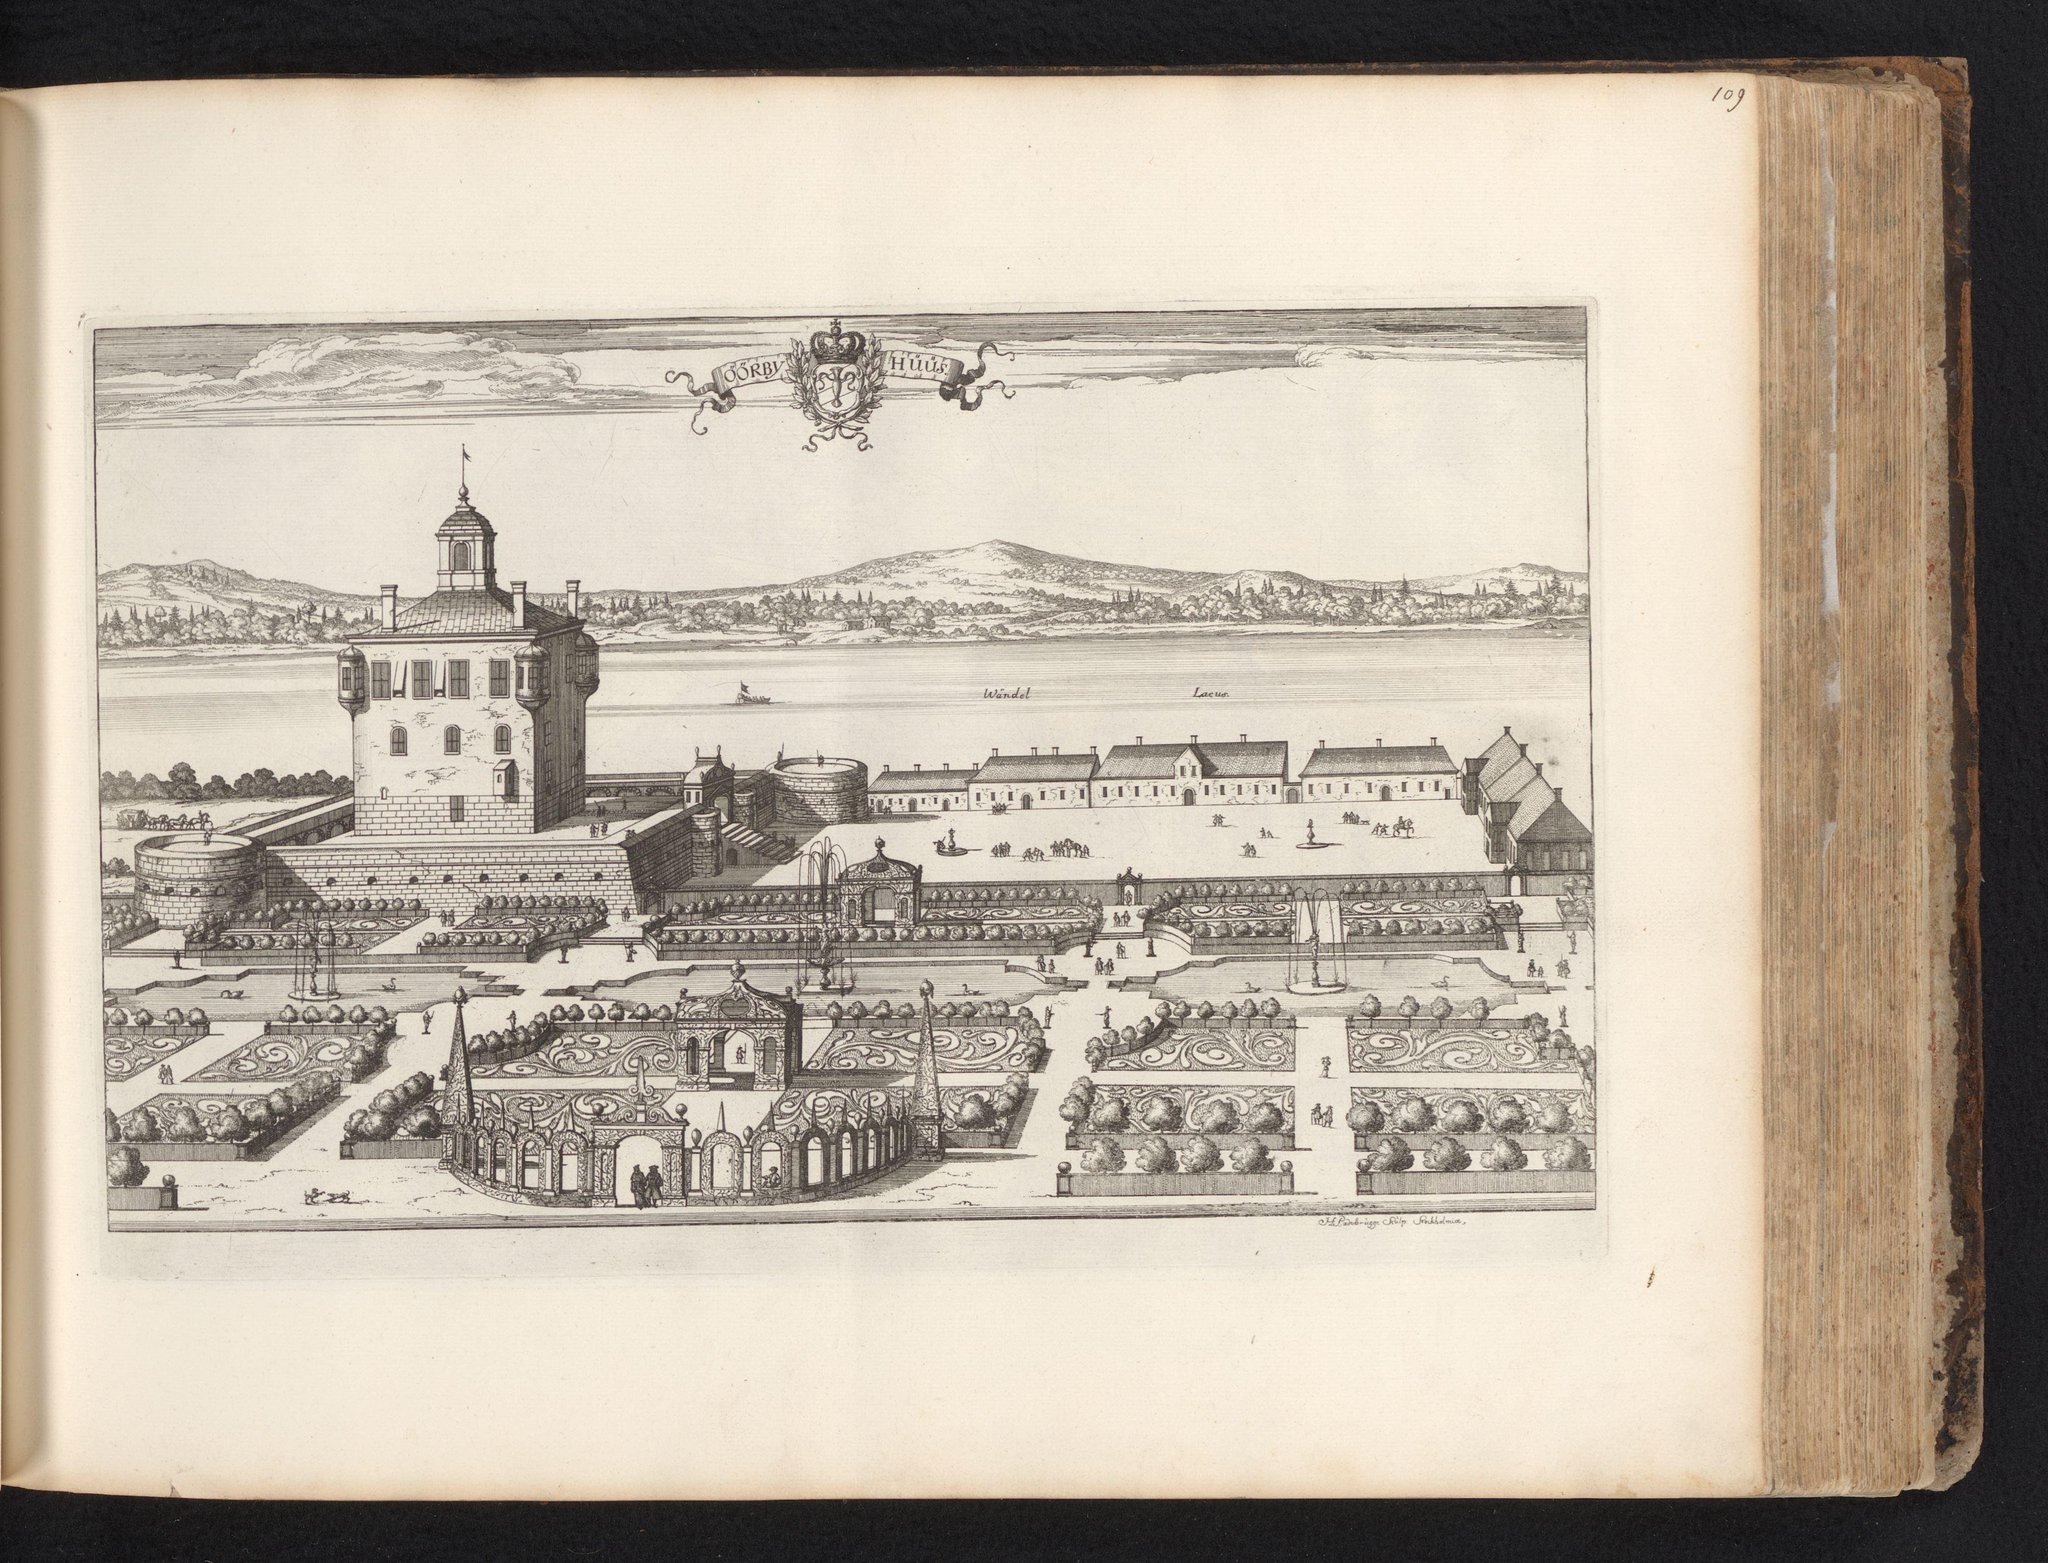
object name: album leaf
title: Öörbyhuus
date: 1686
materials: paper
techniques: etching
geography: stockholm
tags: palace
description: Kungliga Biblioteket, 'Suecia': http://www.kb.se/samlingarna/Kartor-bilder/Suecia-antiqua/ (geraadpleegd november 2016).